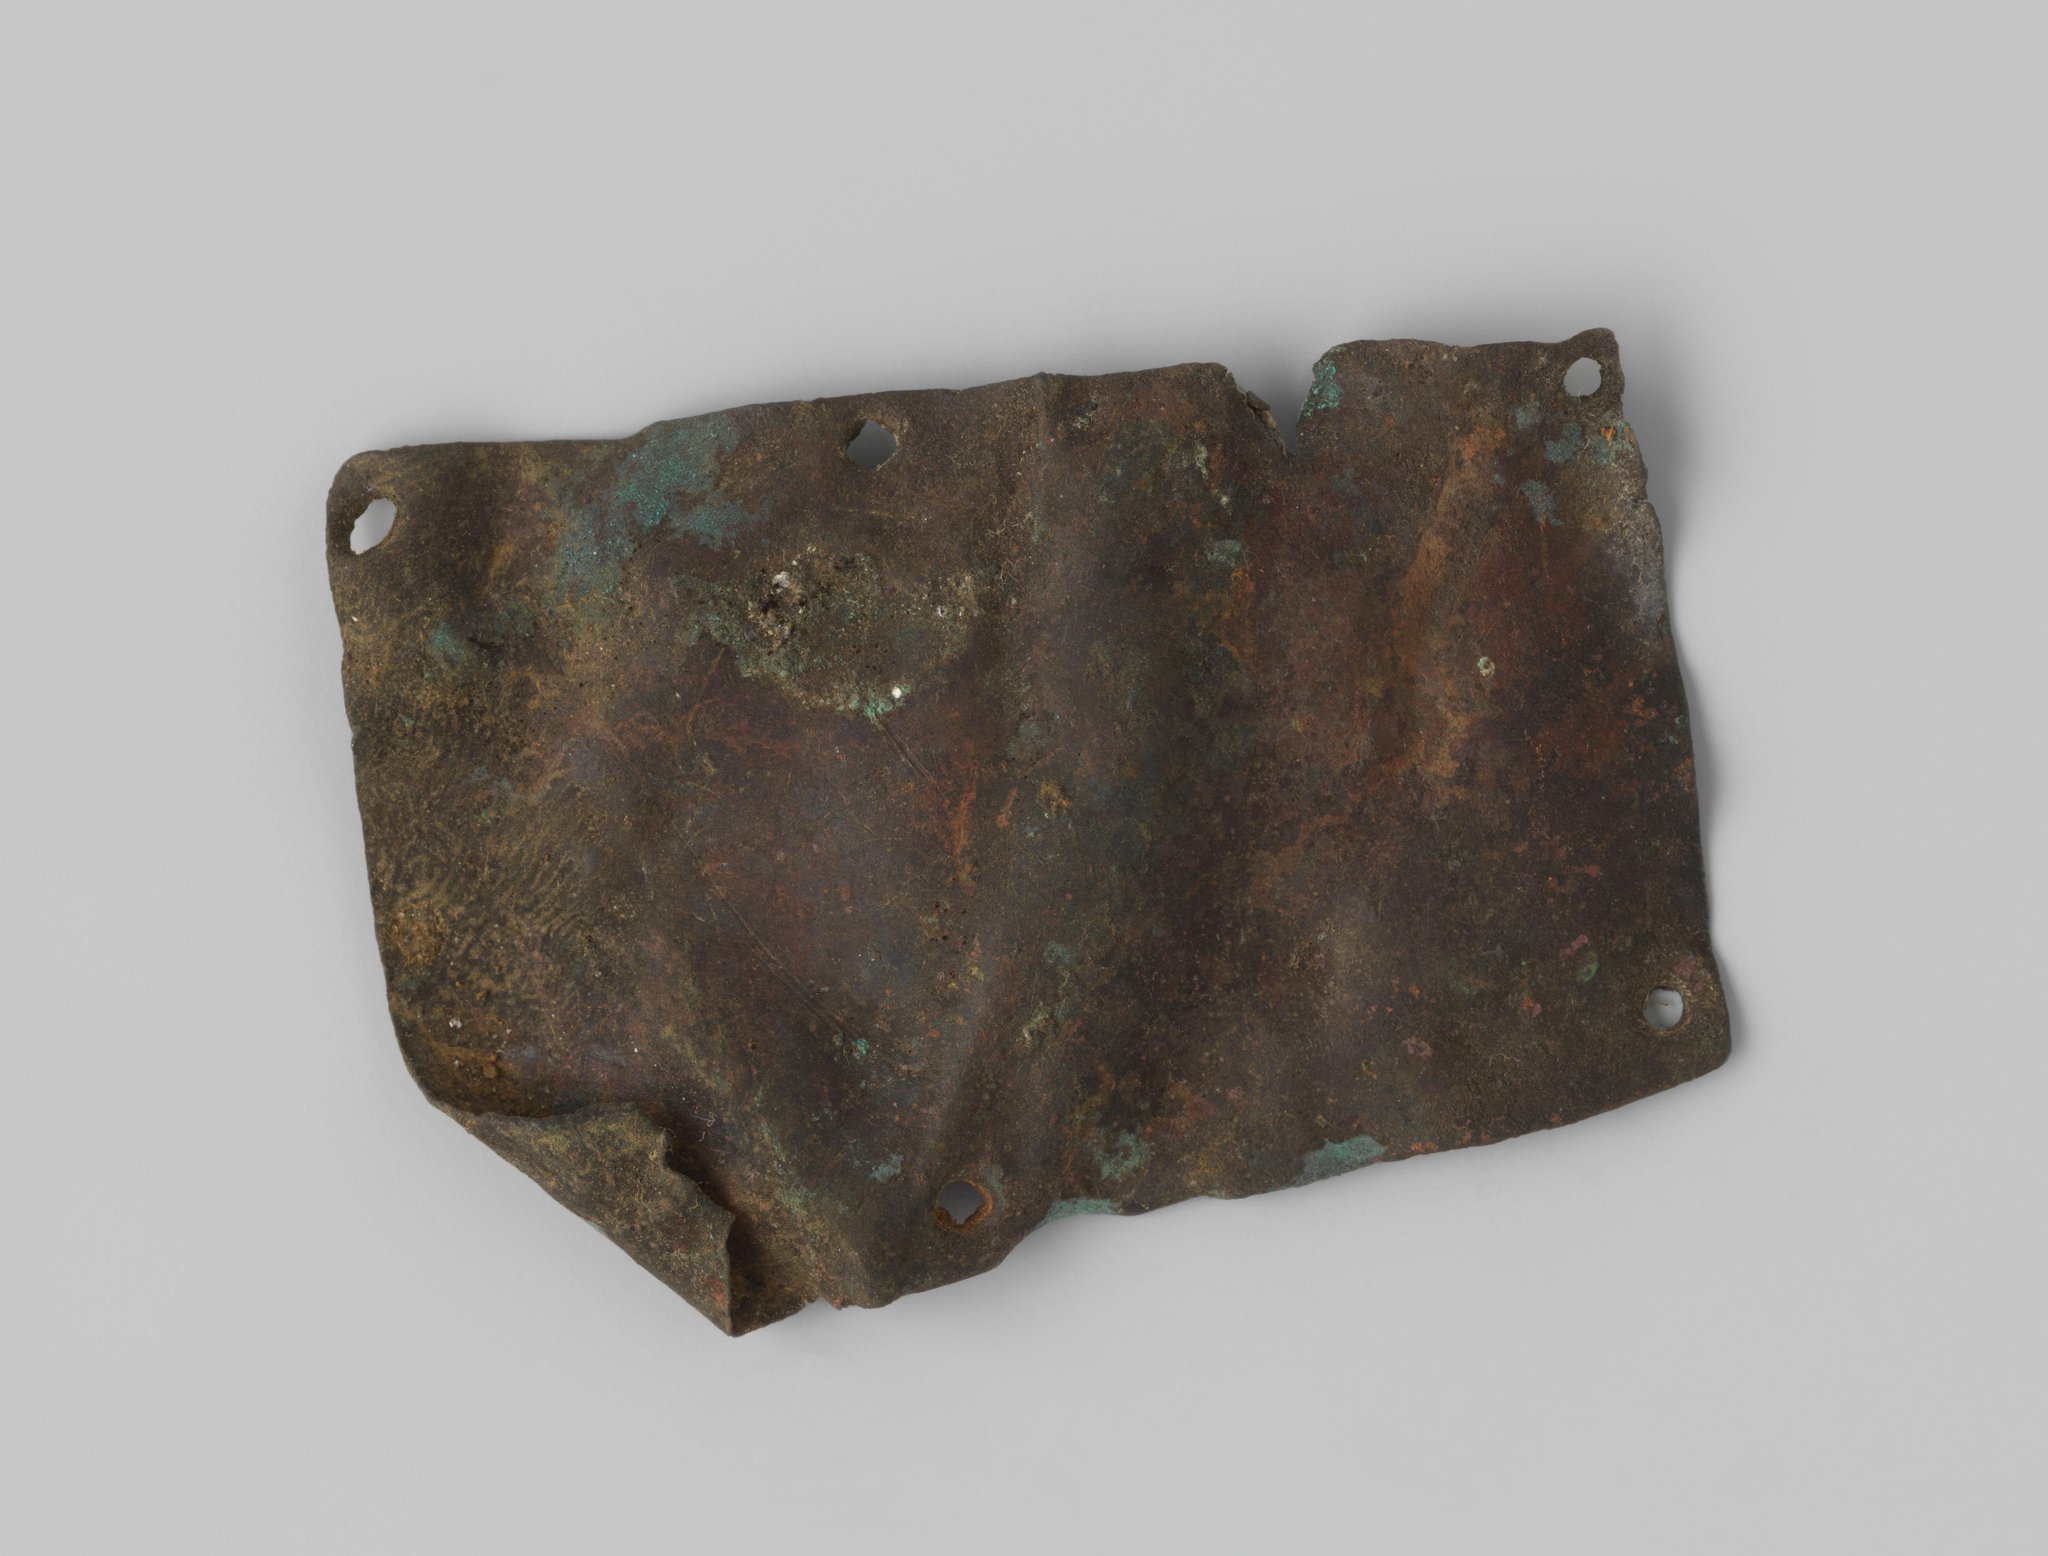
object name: kolfplaat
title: Kolfplaat van een musket uit het wrak van de Oost-Indiëvaarder Hollandia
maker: Anonymous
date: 1700-1743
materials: copper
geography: netherlands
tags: verenigde oostindische compagnie, hollandia (schip), annet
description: Musket, butt-plate; squashed, id. NG 1979-207H3071.